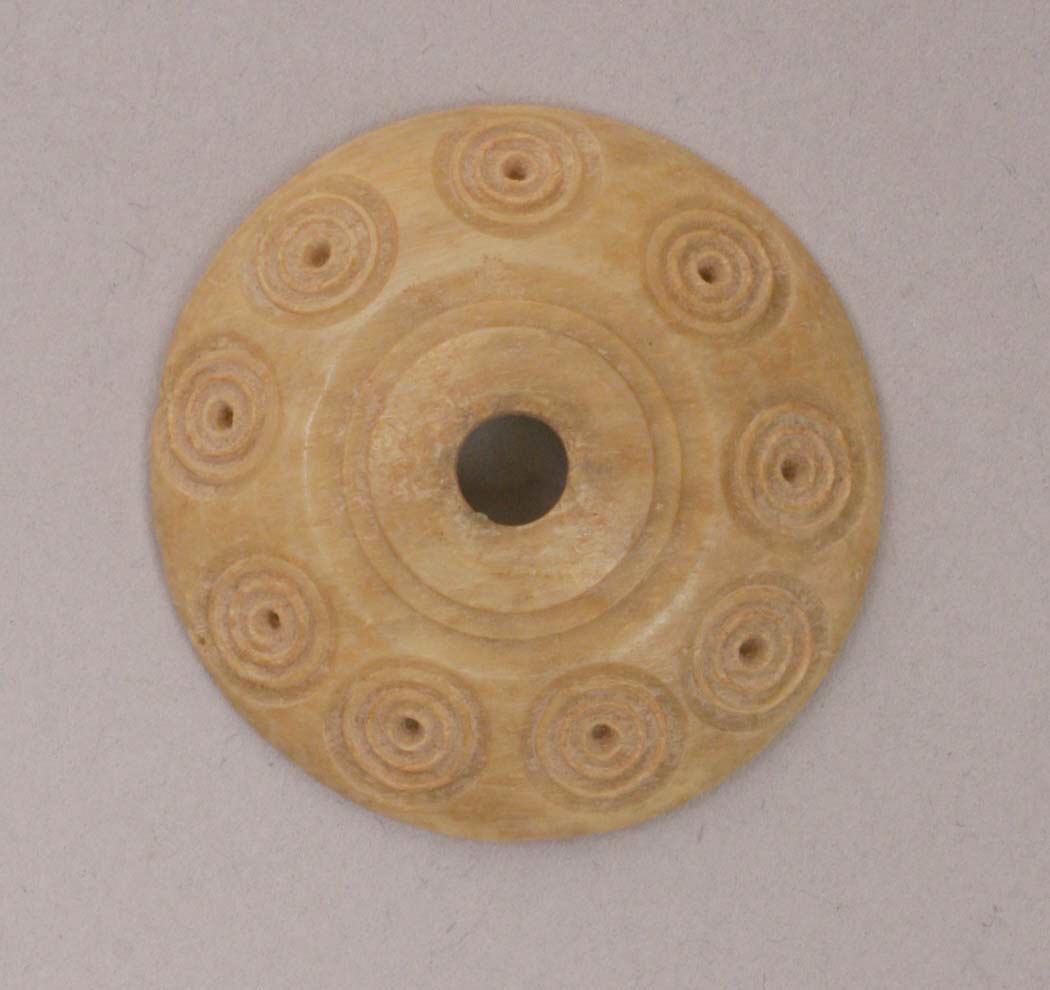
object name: button or bead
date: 801-1000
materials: bone, paint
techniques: incising, inlay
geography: iran